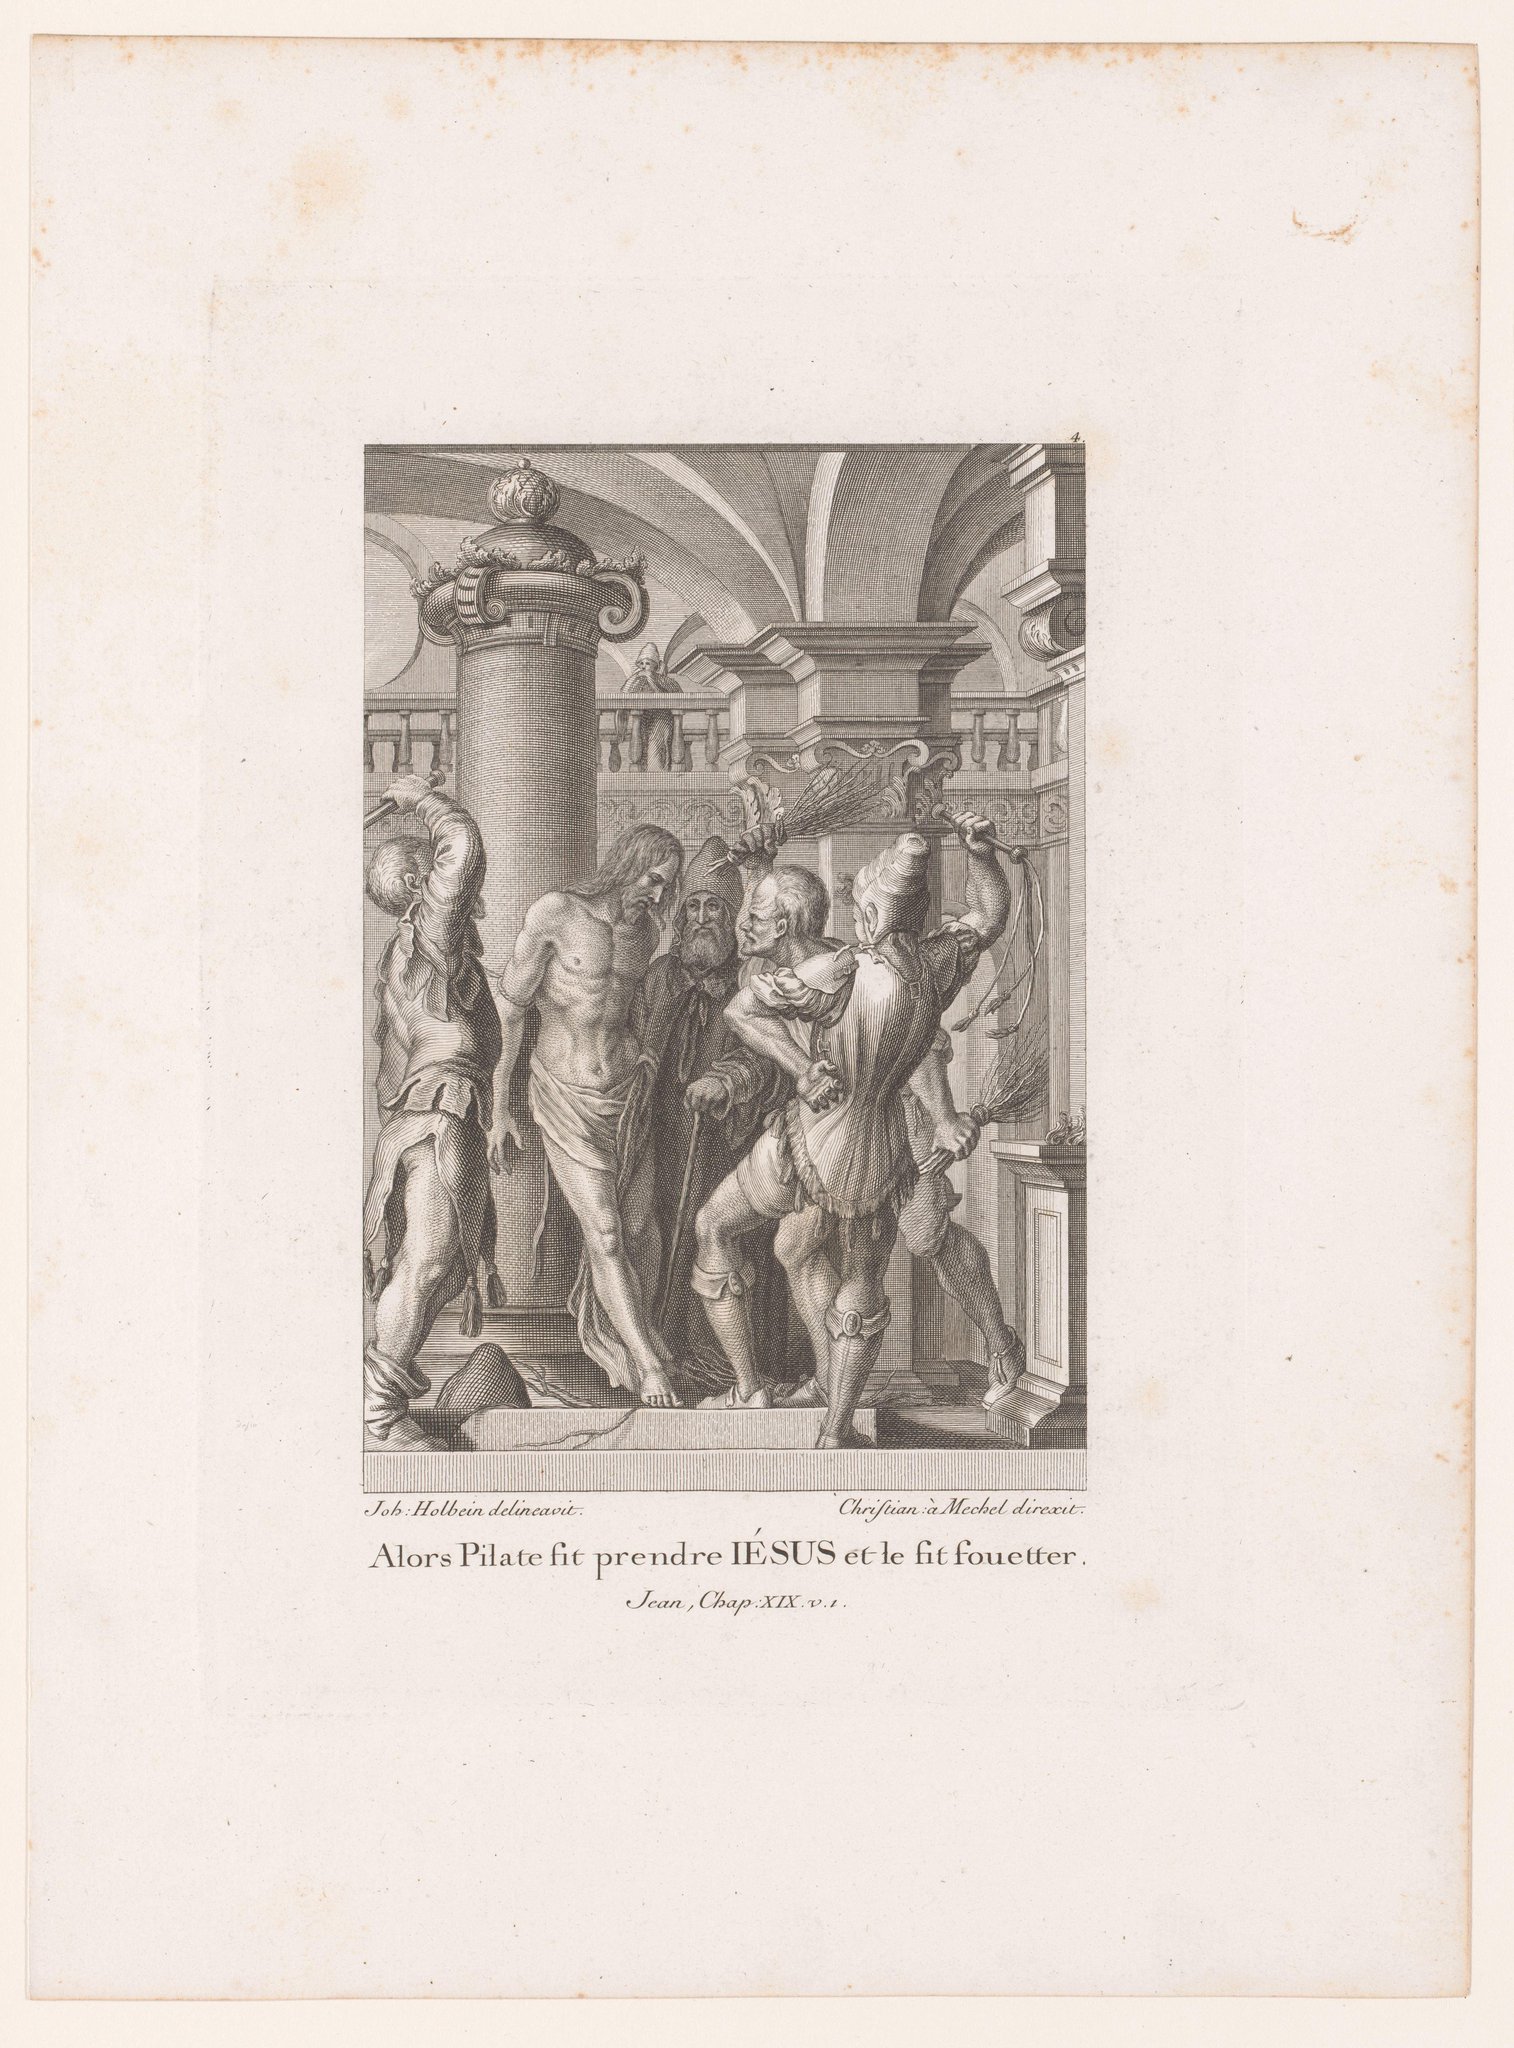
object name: print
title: Passie van Christus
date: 1784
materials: paper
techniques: etching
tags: religious functionaries ~ jewish religion, balustrade, corinthian order ~ architecture, flagellation by soldiers, christ usually tied to a column (matthew 27:26; mark 15:15; john 19:1)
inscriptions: collector's mark: Lugt 4404, collector's mark: Lugt 2228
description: Christus staat gebonden aan een zuil in een tempelruimte. Hij wordt gegeseld door drie soldaten terwijl een oude hogepriester toekijkt.